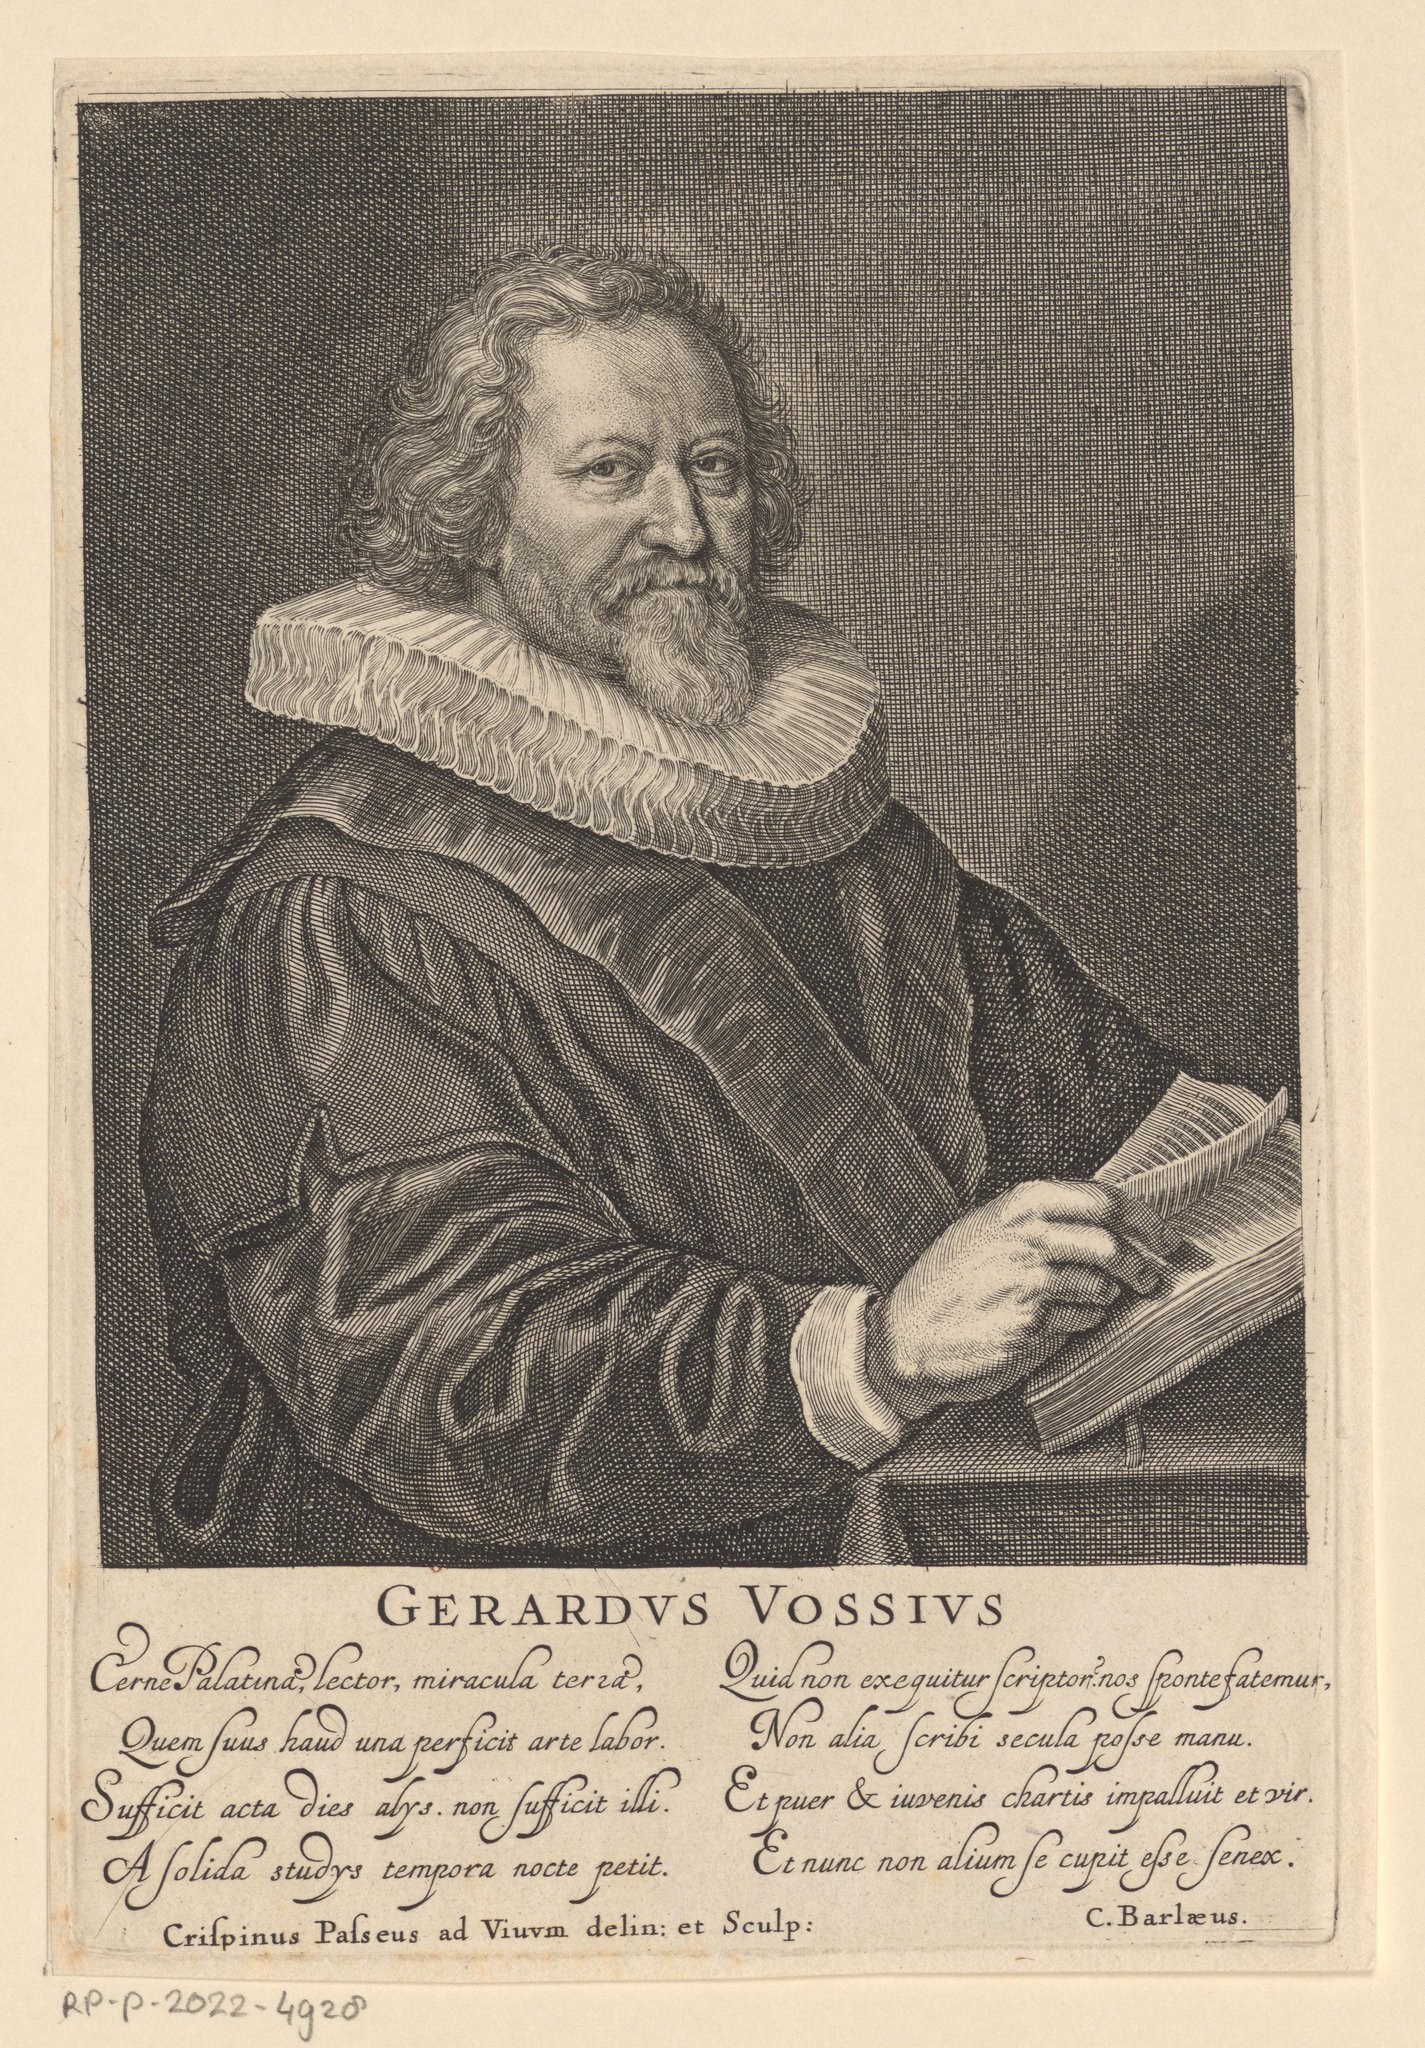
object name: print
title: Portret van Gerardus Joannes Vossius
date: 1620-1670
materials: paper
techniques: engraving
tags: amsterdam, gerardus joannes vossius, theologian, historical persons, portrait of a writer